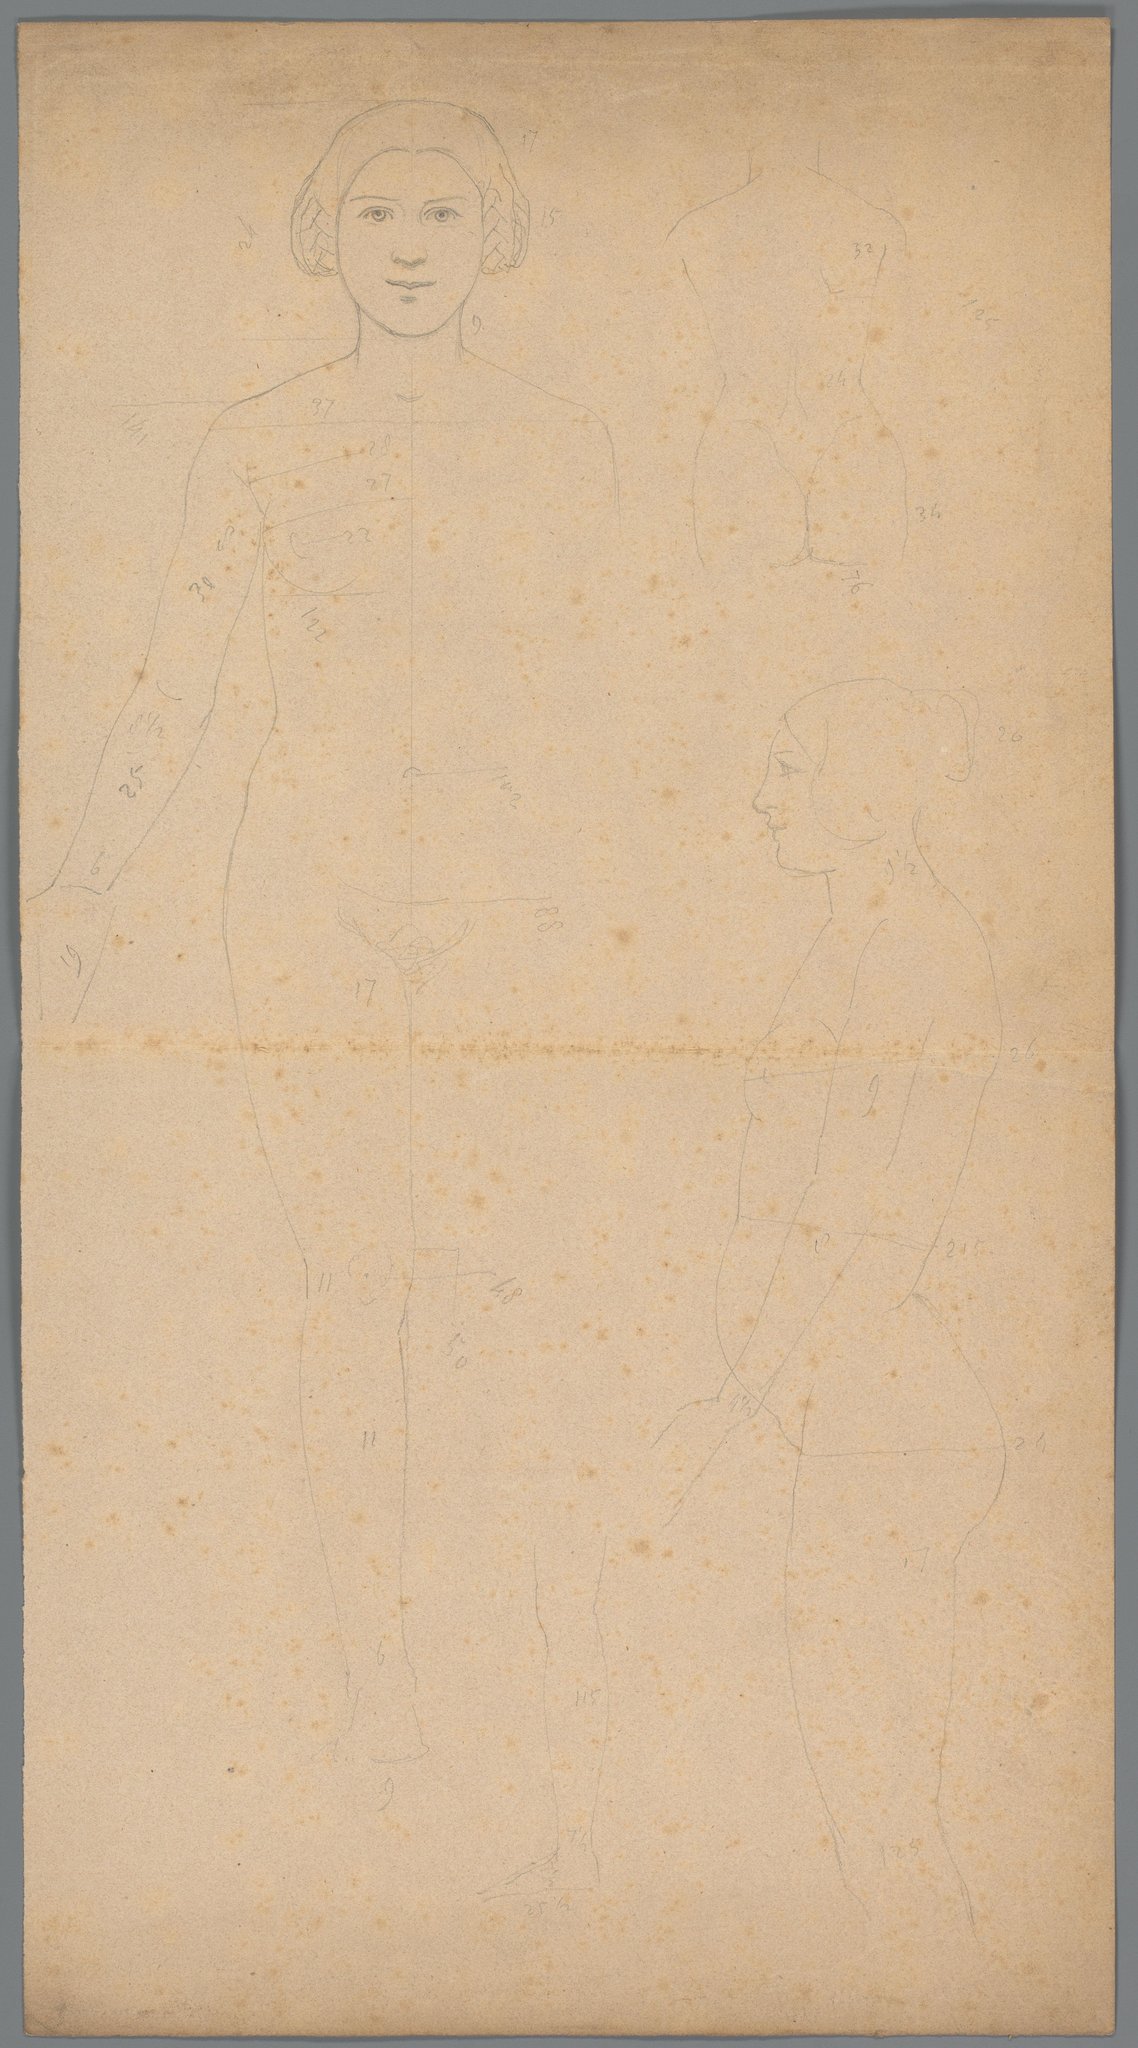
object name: drawing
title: Studie van een vrouw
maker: jacobus everhardus josephus van den berg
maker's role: draughtsman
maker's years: 1802-1861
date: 1812-1861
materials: paper, pencil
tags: the (nude) human figure; 'corpo humano' (ripa) - aa - female human figure